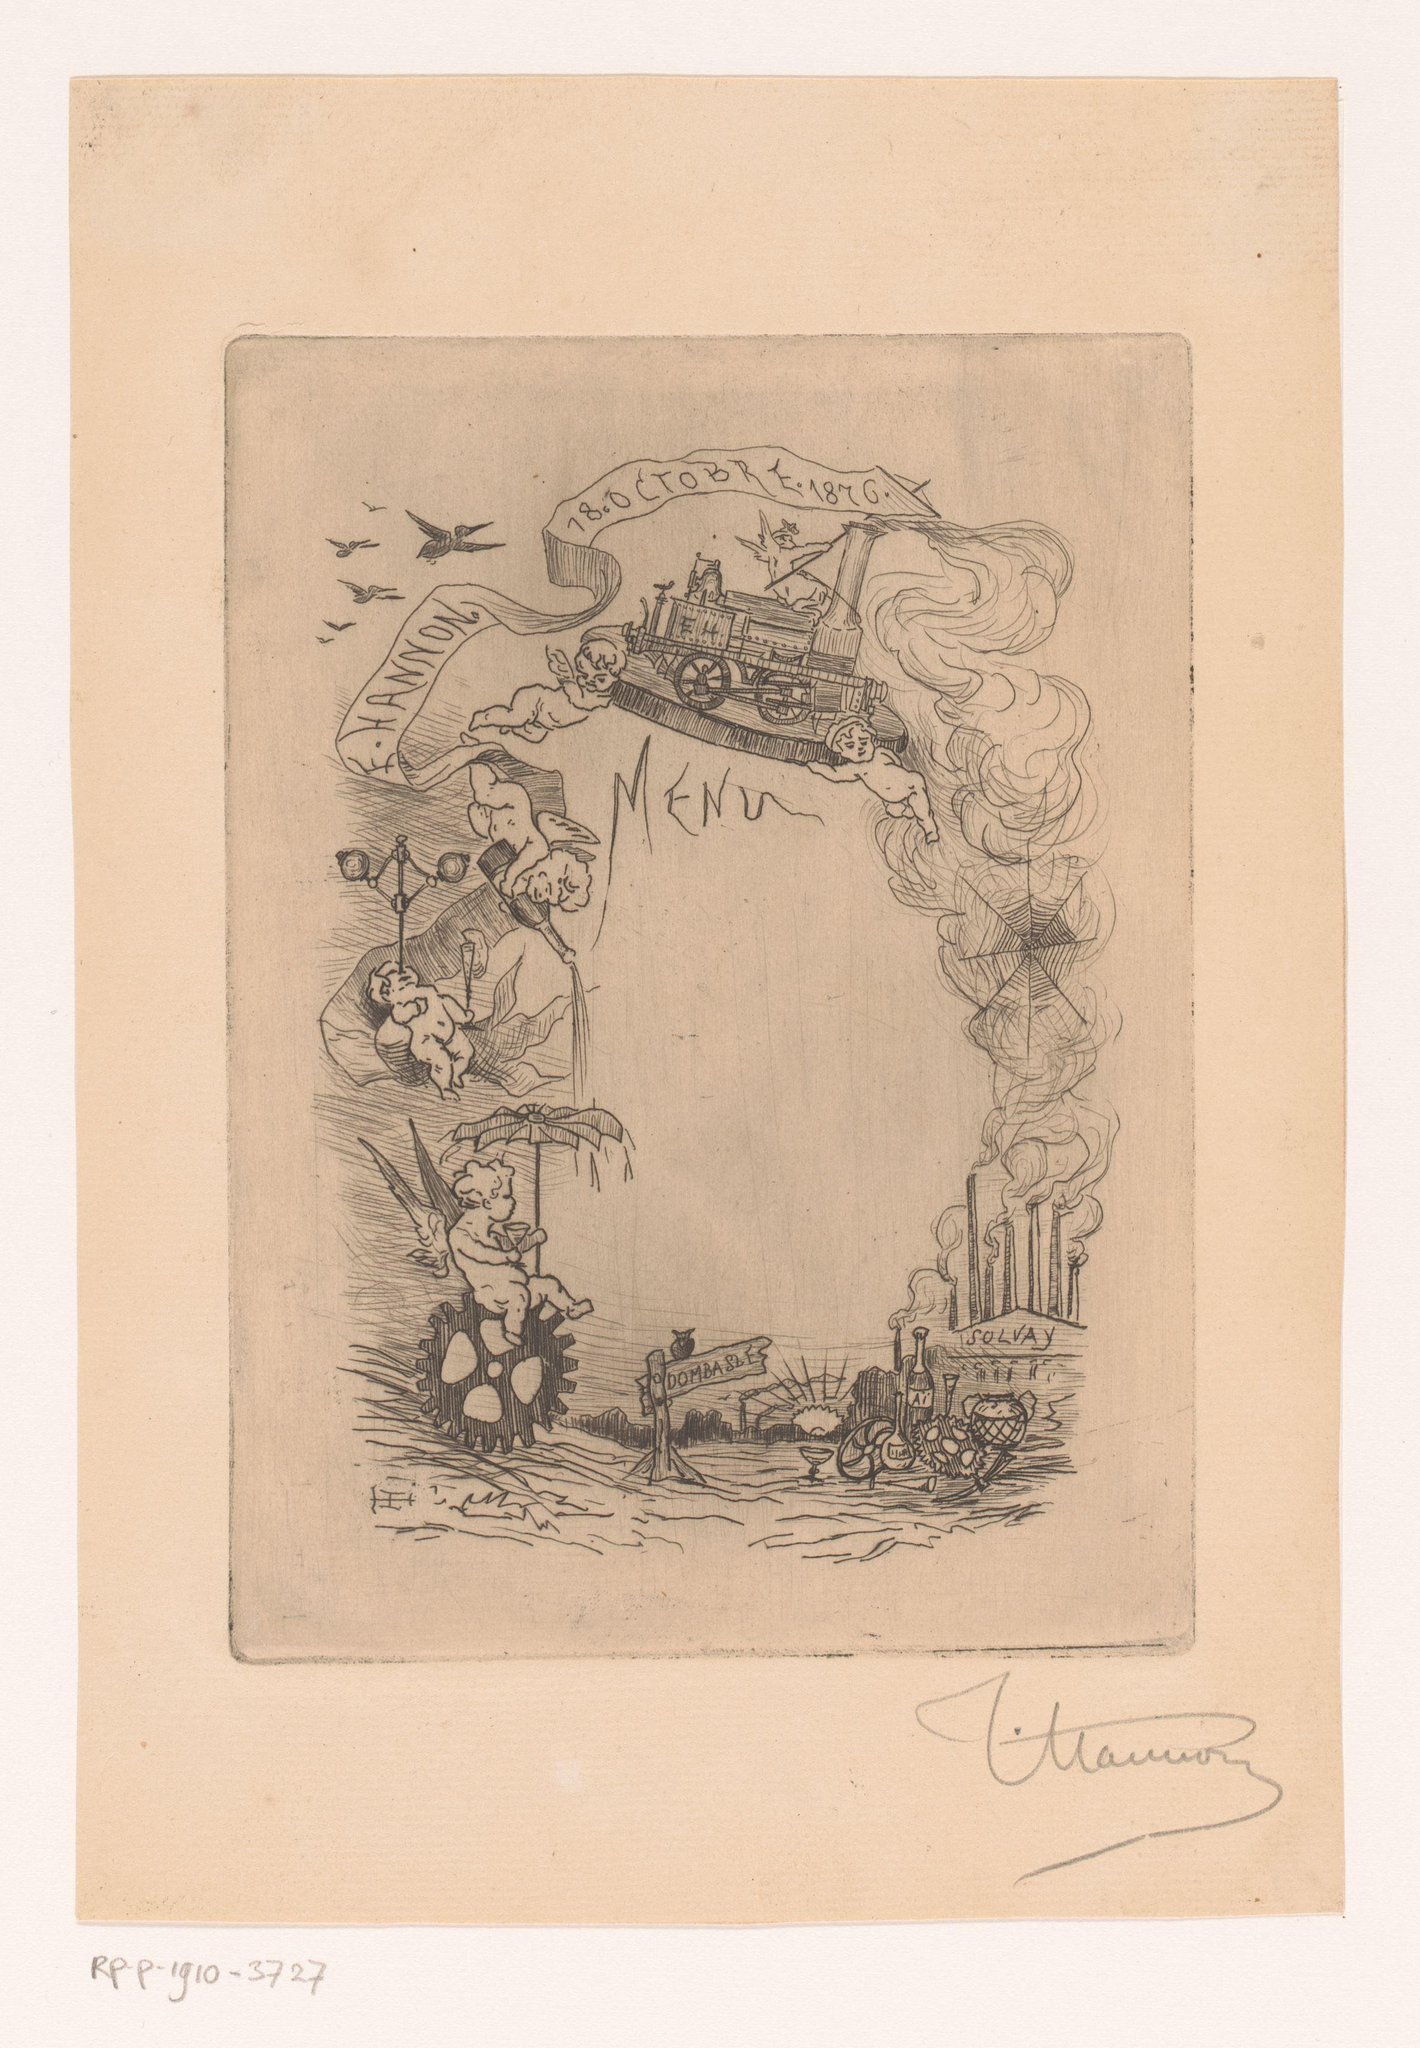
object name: menu, menukaart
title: Menu E. Hannon 18 Octobre 1876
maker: theodoor hannon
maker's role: print maker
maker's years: 1851-1917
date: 1876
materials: paper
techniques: etching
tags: factory-building, cupids: 'amores', 'amoretti', 'putti', steam locomotive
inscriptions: collector's mark: Lugt 2228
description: Deze prent is waarschijnlijk bedoeld als illustratie van het menu van een feest van de broer van de prentmaker: Edouard Hannon. Edouard maakt carrière bij het bedrijf Solvay als ingenieur.